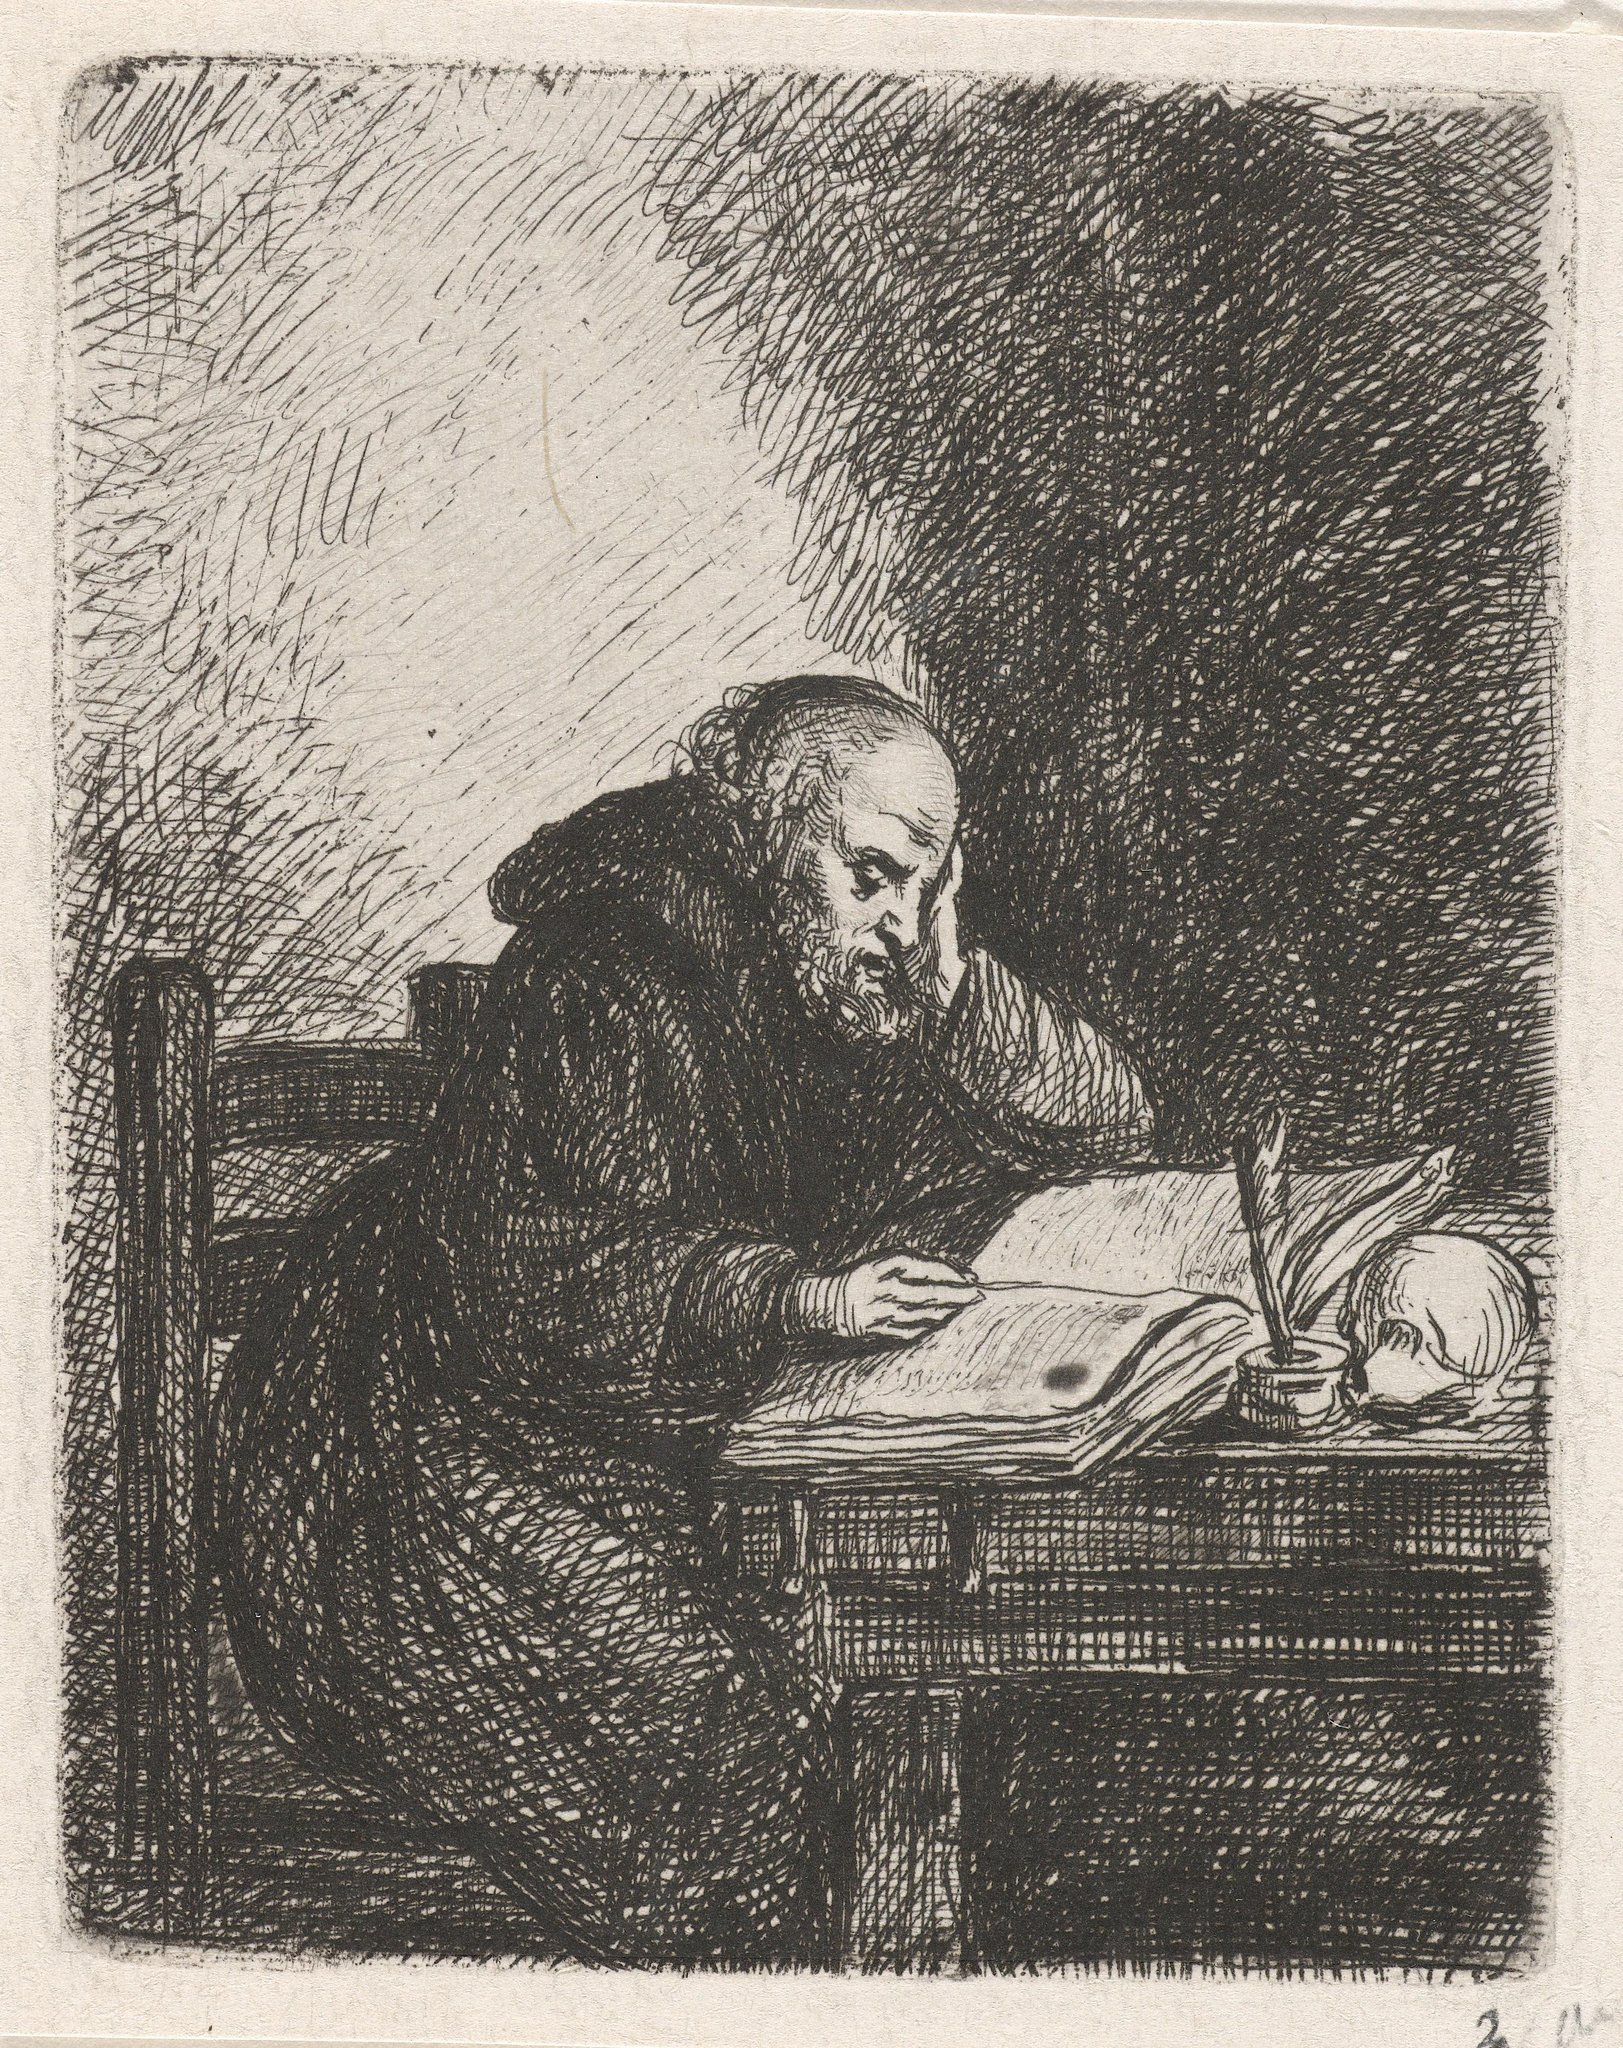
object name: print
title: Lezende monnik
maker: david van der kellen (1804-1879)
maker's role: die cutter, draughtsman, print maker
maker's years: 1804-1879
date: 1814-1859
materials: paper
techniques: drypoint, etching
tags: reading, (human) skull, monk(s), friar(s)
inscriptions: inscription: ‘Present exemplaar 3’, collector's mark: Lugt 2228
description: In een vertrek zit een monnik aan tafel een boek te lezen. Op de tafel staan een schedel en een inktpot met daarin een schrijfveer.